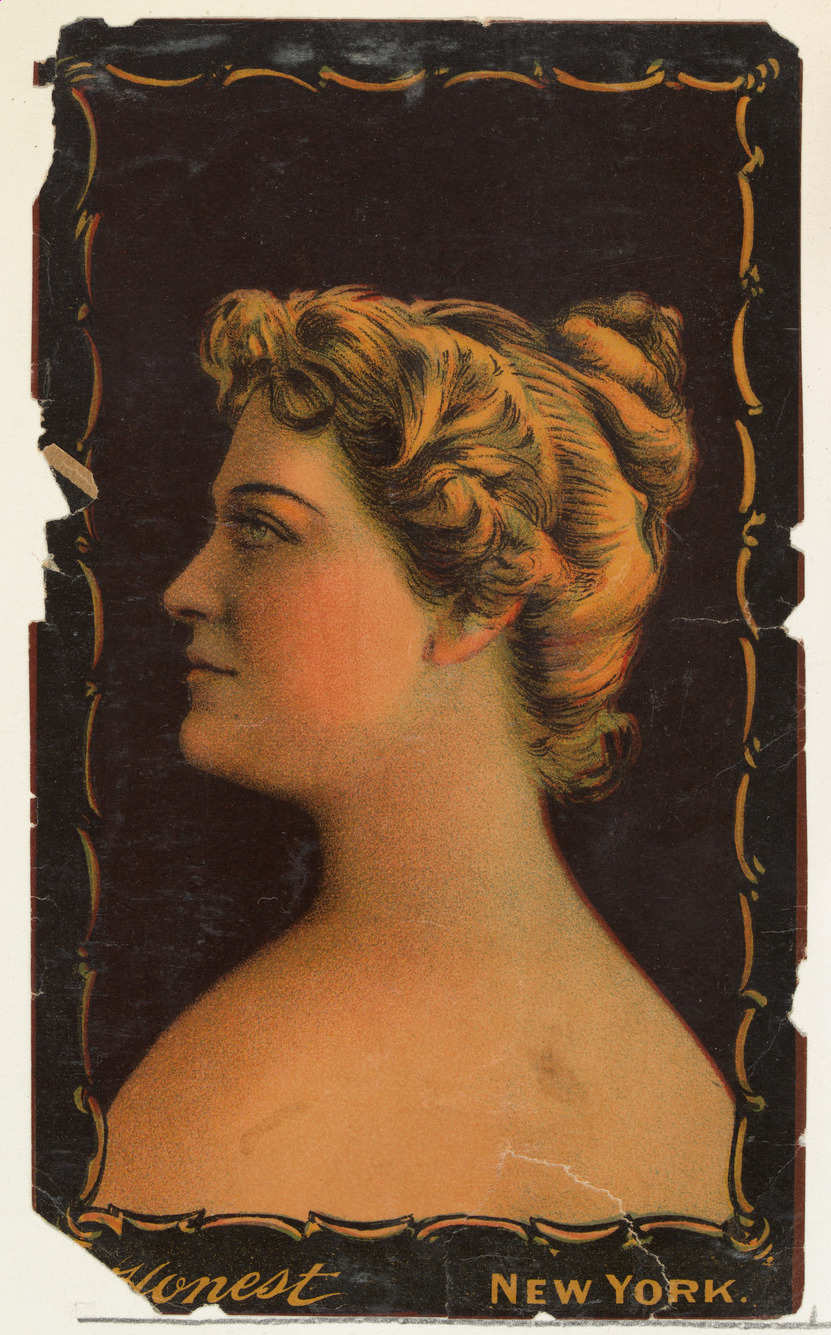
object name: print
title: Portrait of actress facing left, from the Transparencies series (N137) issued by W. Duke, Sons & Co. to promote Honest Long Cut Tobacco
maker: w. duke, sons & co.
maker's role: publisher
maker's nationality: american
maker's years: 1870-1920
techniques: color lithograph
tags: profiles,women,actresses